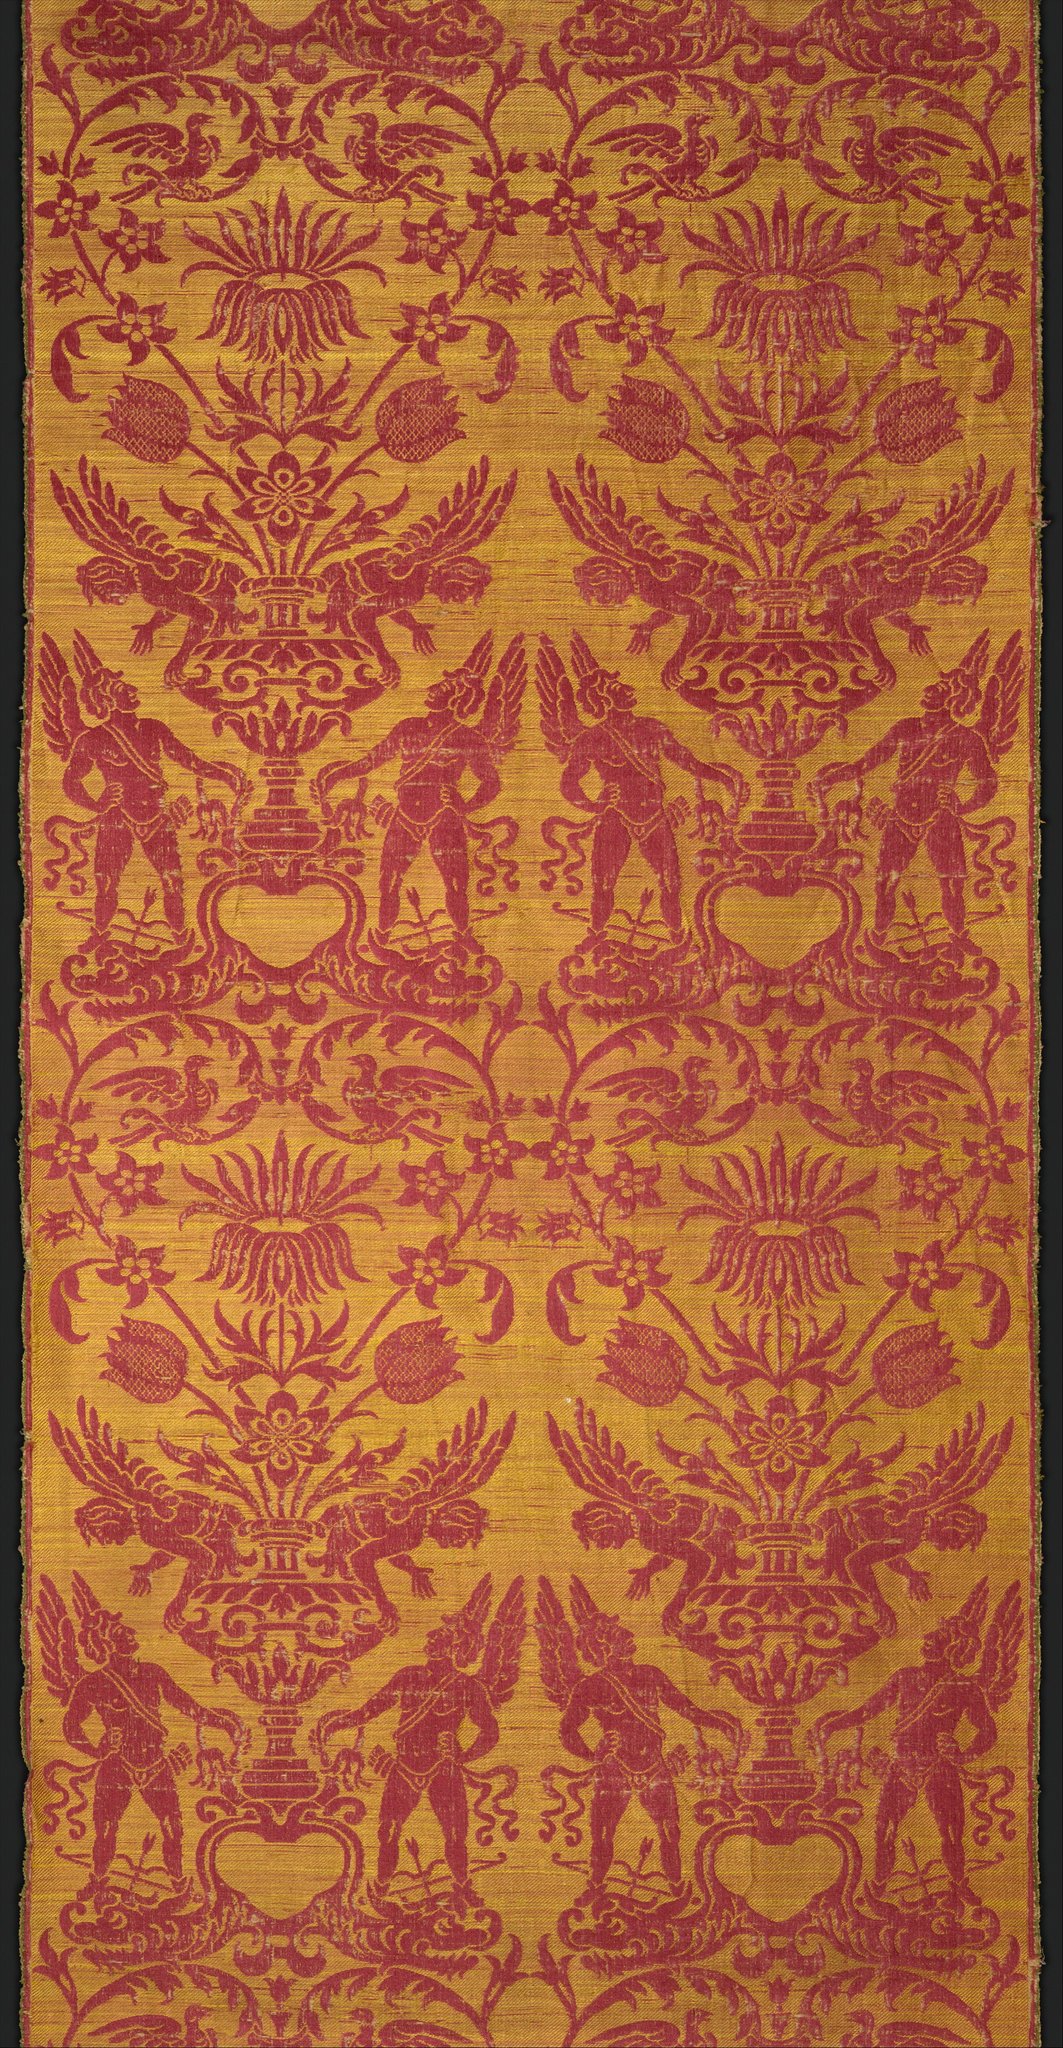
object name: length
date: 1601-1700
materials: silk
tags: birds,cupid,flowers